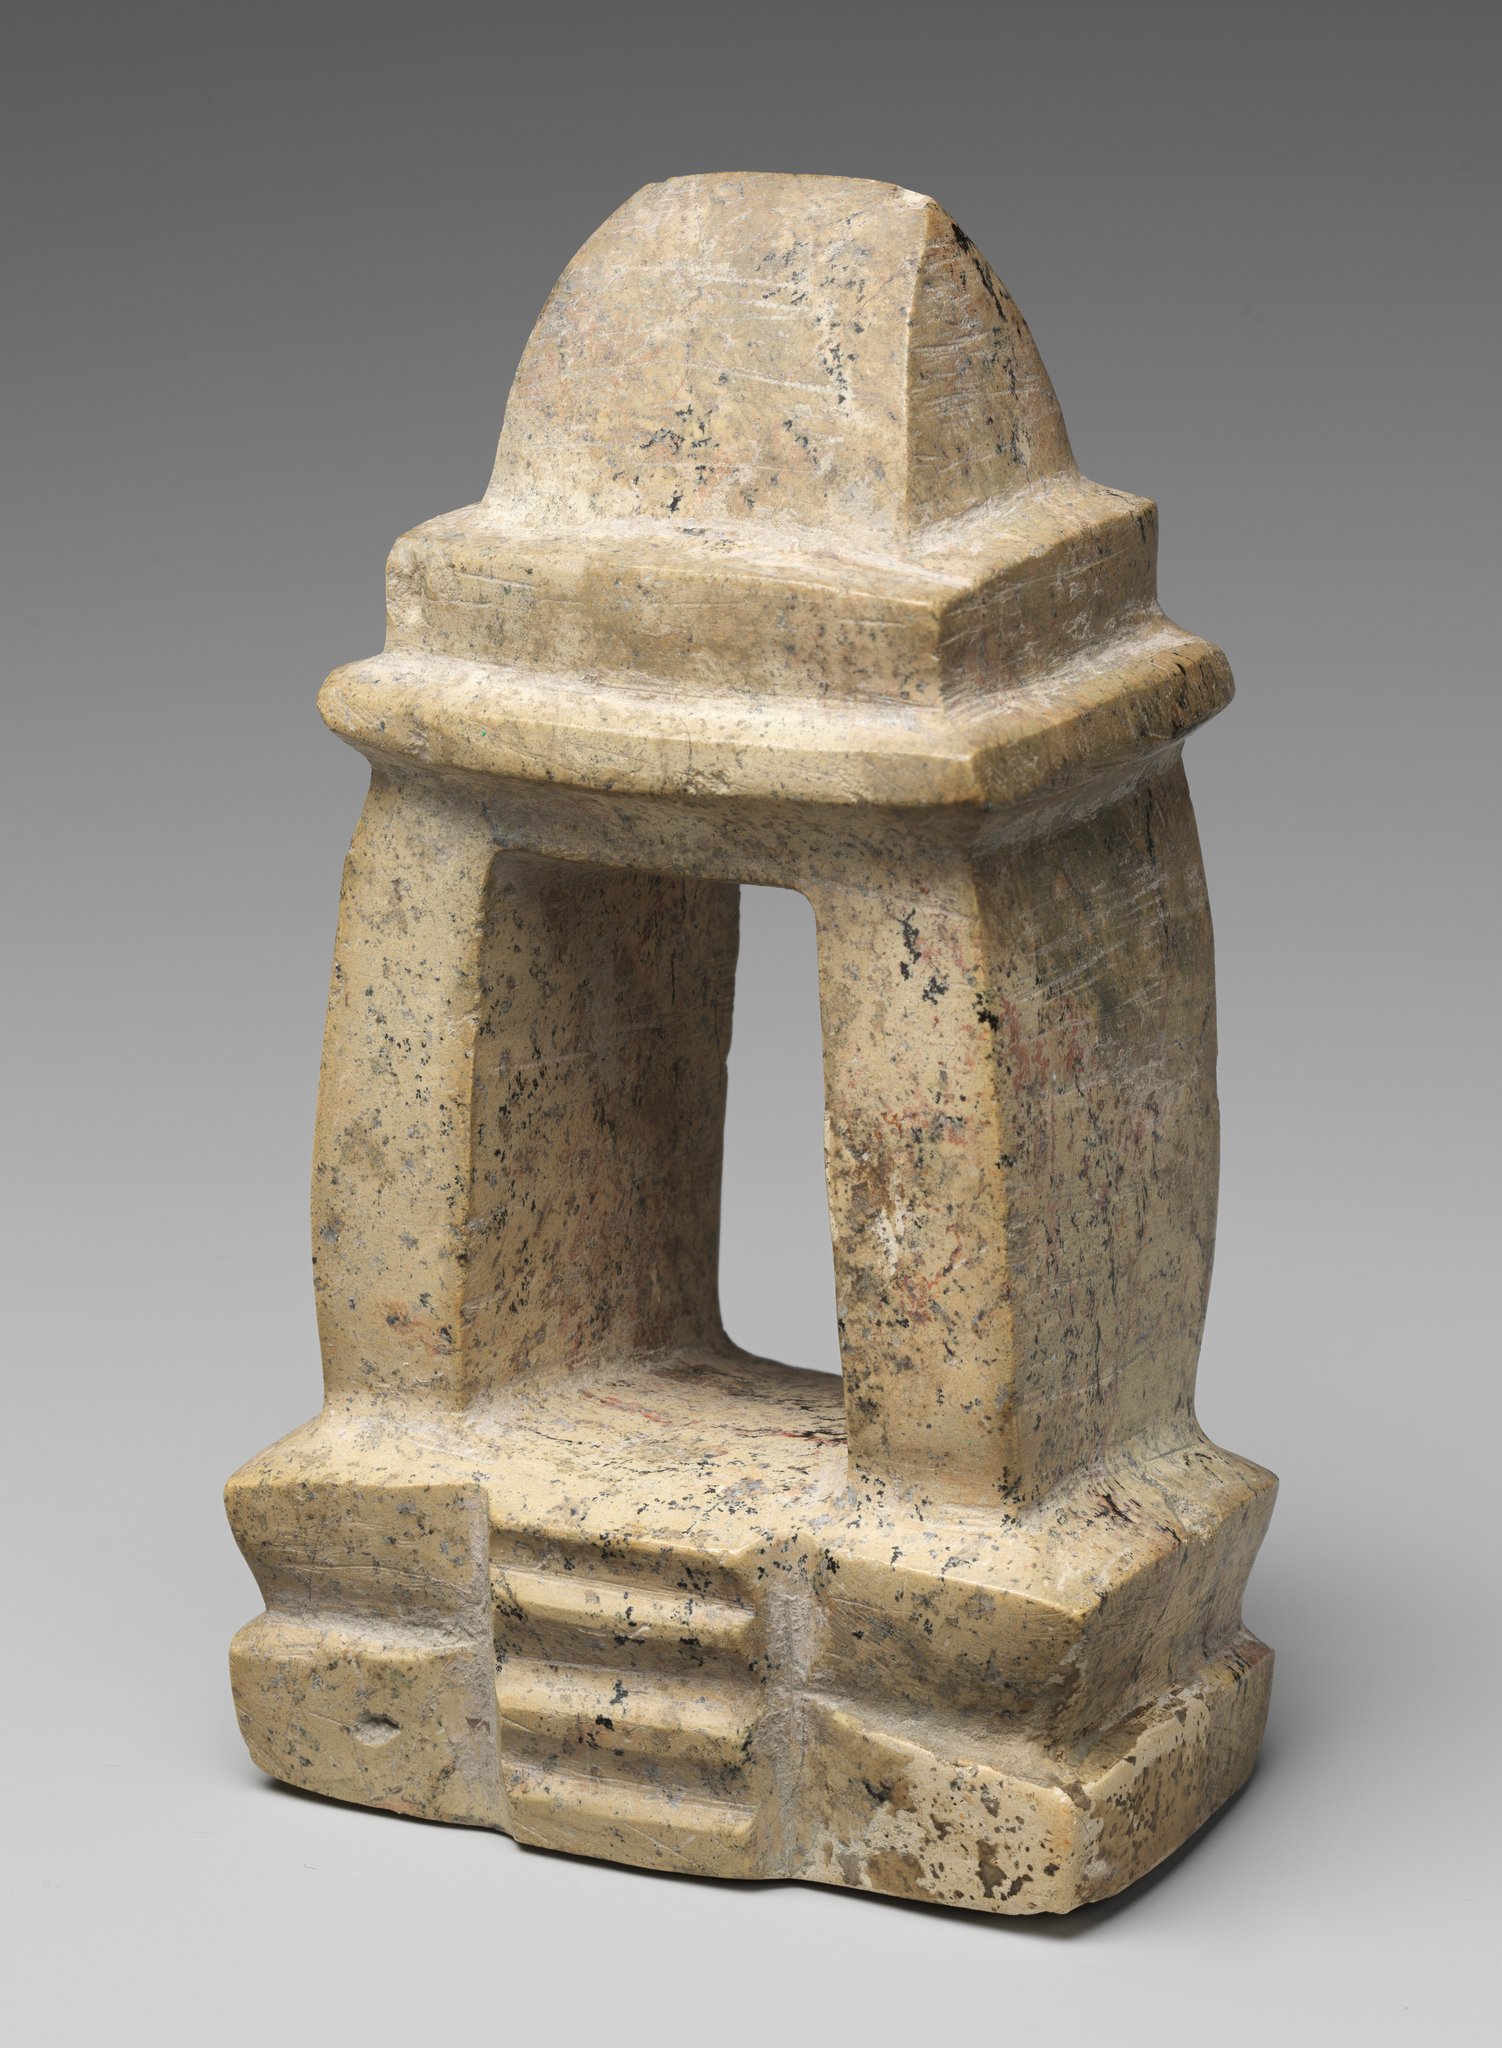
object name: architectural model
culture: mezcala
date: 1-800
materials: stone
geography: mexico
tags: temples